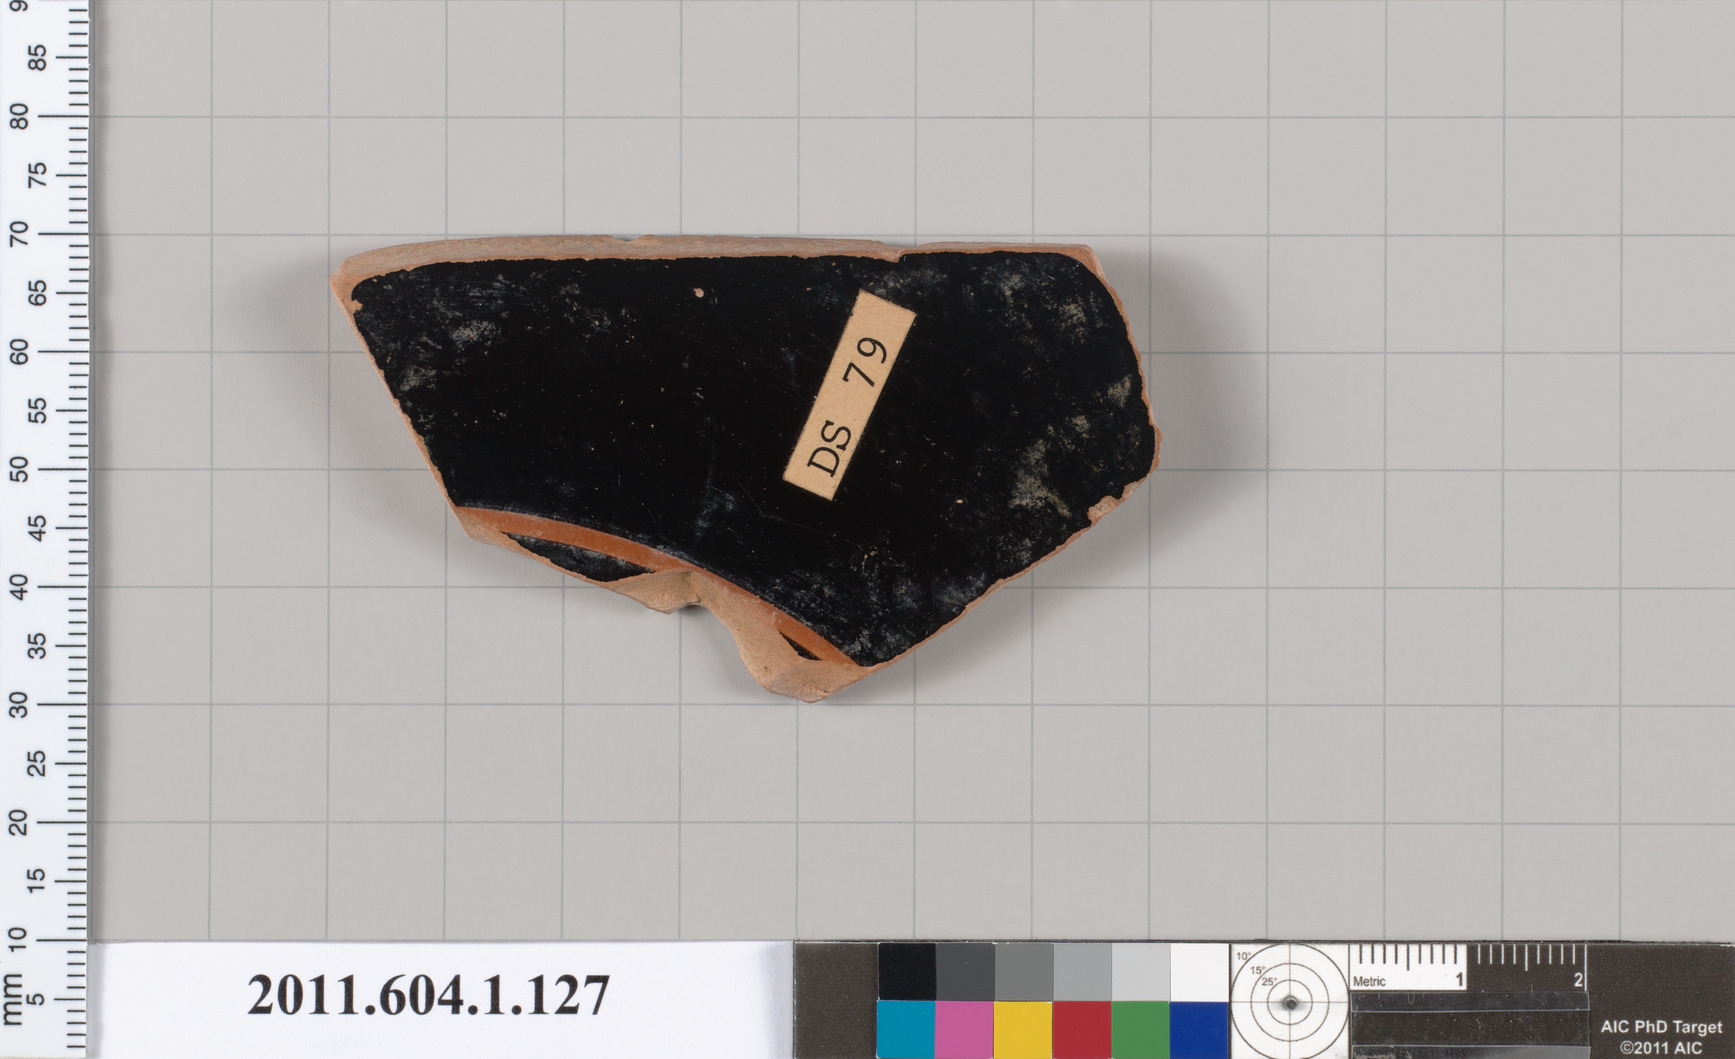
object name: kylix fragment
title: Terracotta fragment of a kylix (drinking cup)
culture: greek, attic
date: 475-451 BCE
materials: terracotta